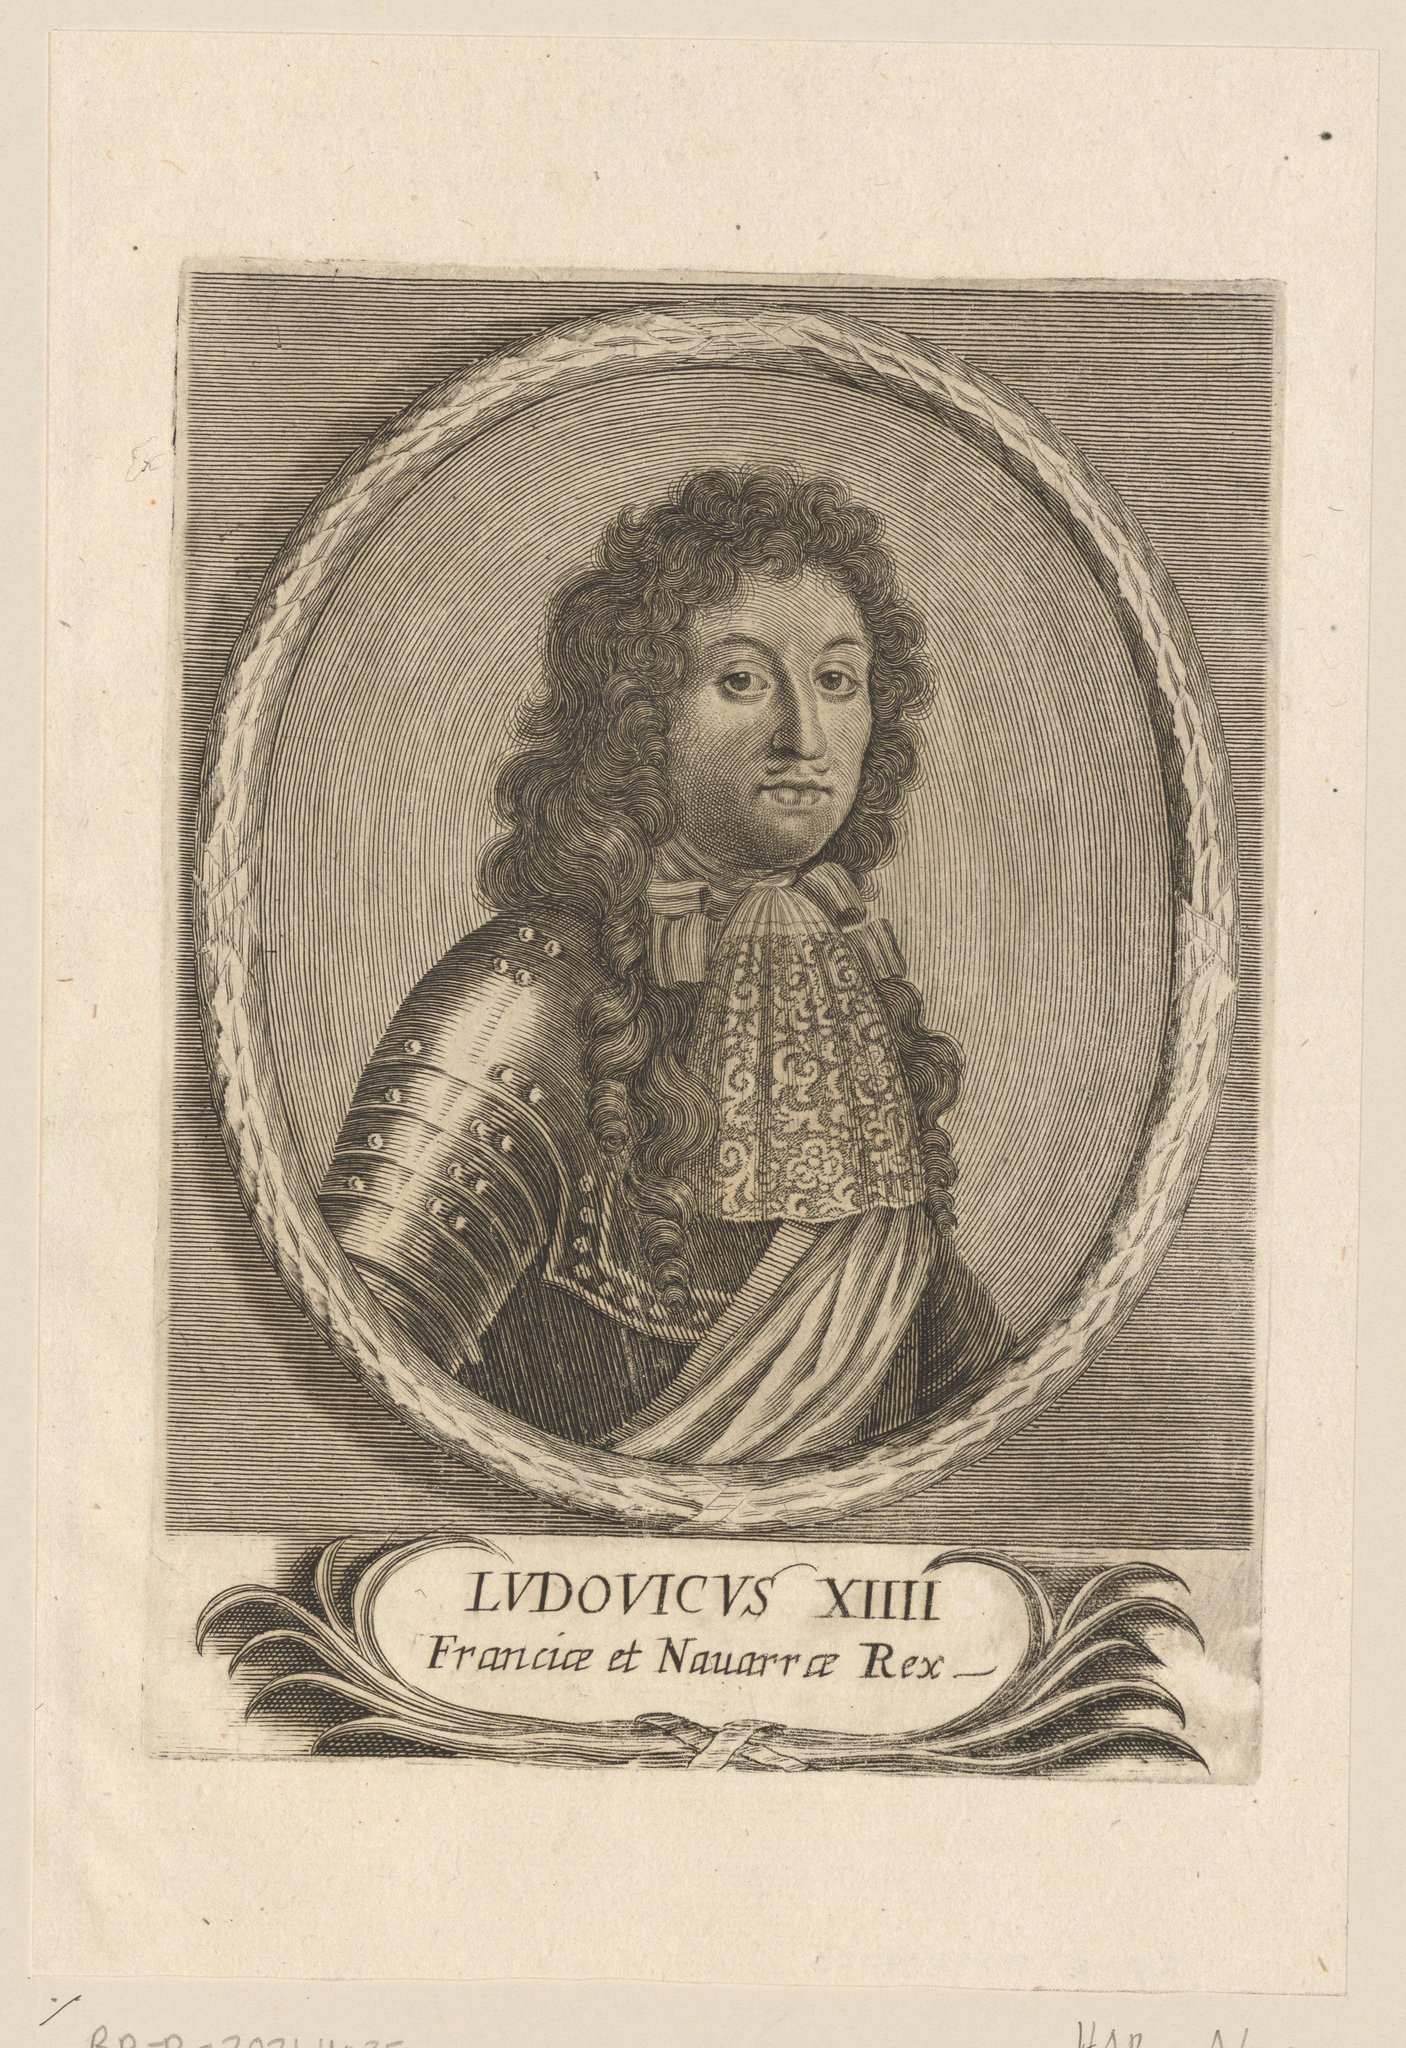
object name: print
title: Portret van Lodewijk XIV van Frankrijk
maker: Anonymous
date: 1682-1691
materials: paper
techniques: engraving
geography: germany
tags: lodewijk xiv (koning van frankrijk), ornament ~ medallion, armour, historical persons, king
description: Prent waarschijnlijk uit: Theatrum Europaeum (...). 1e druk. Frankfurt: erven Matthaus Merian, 1682, dl. 11. Of uit het twaalfde deel uit 1691.